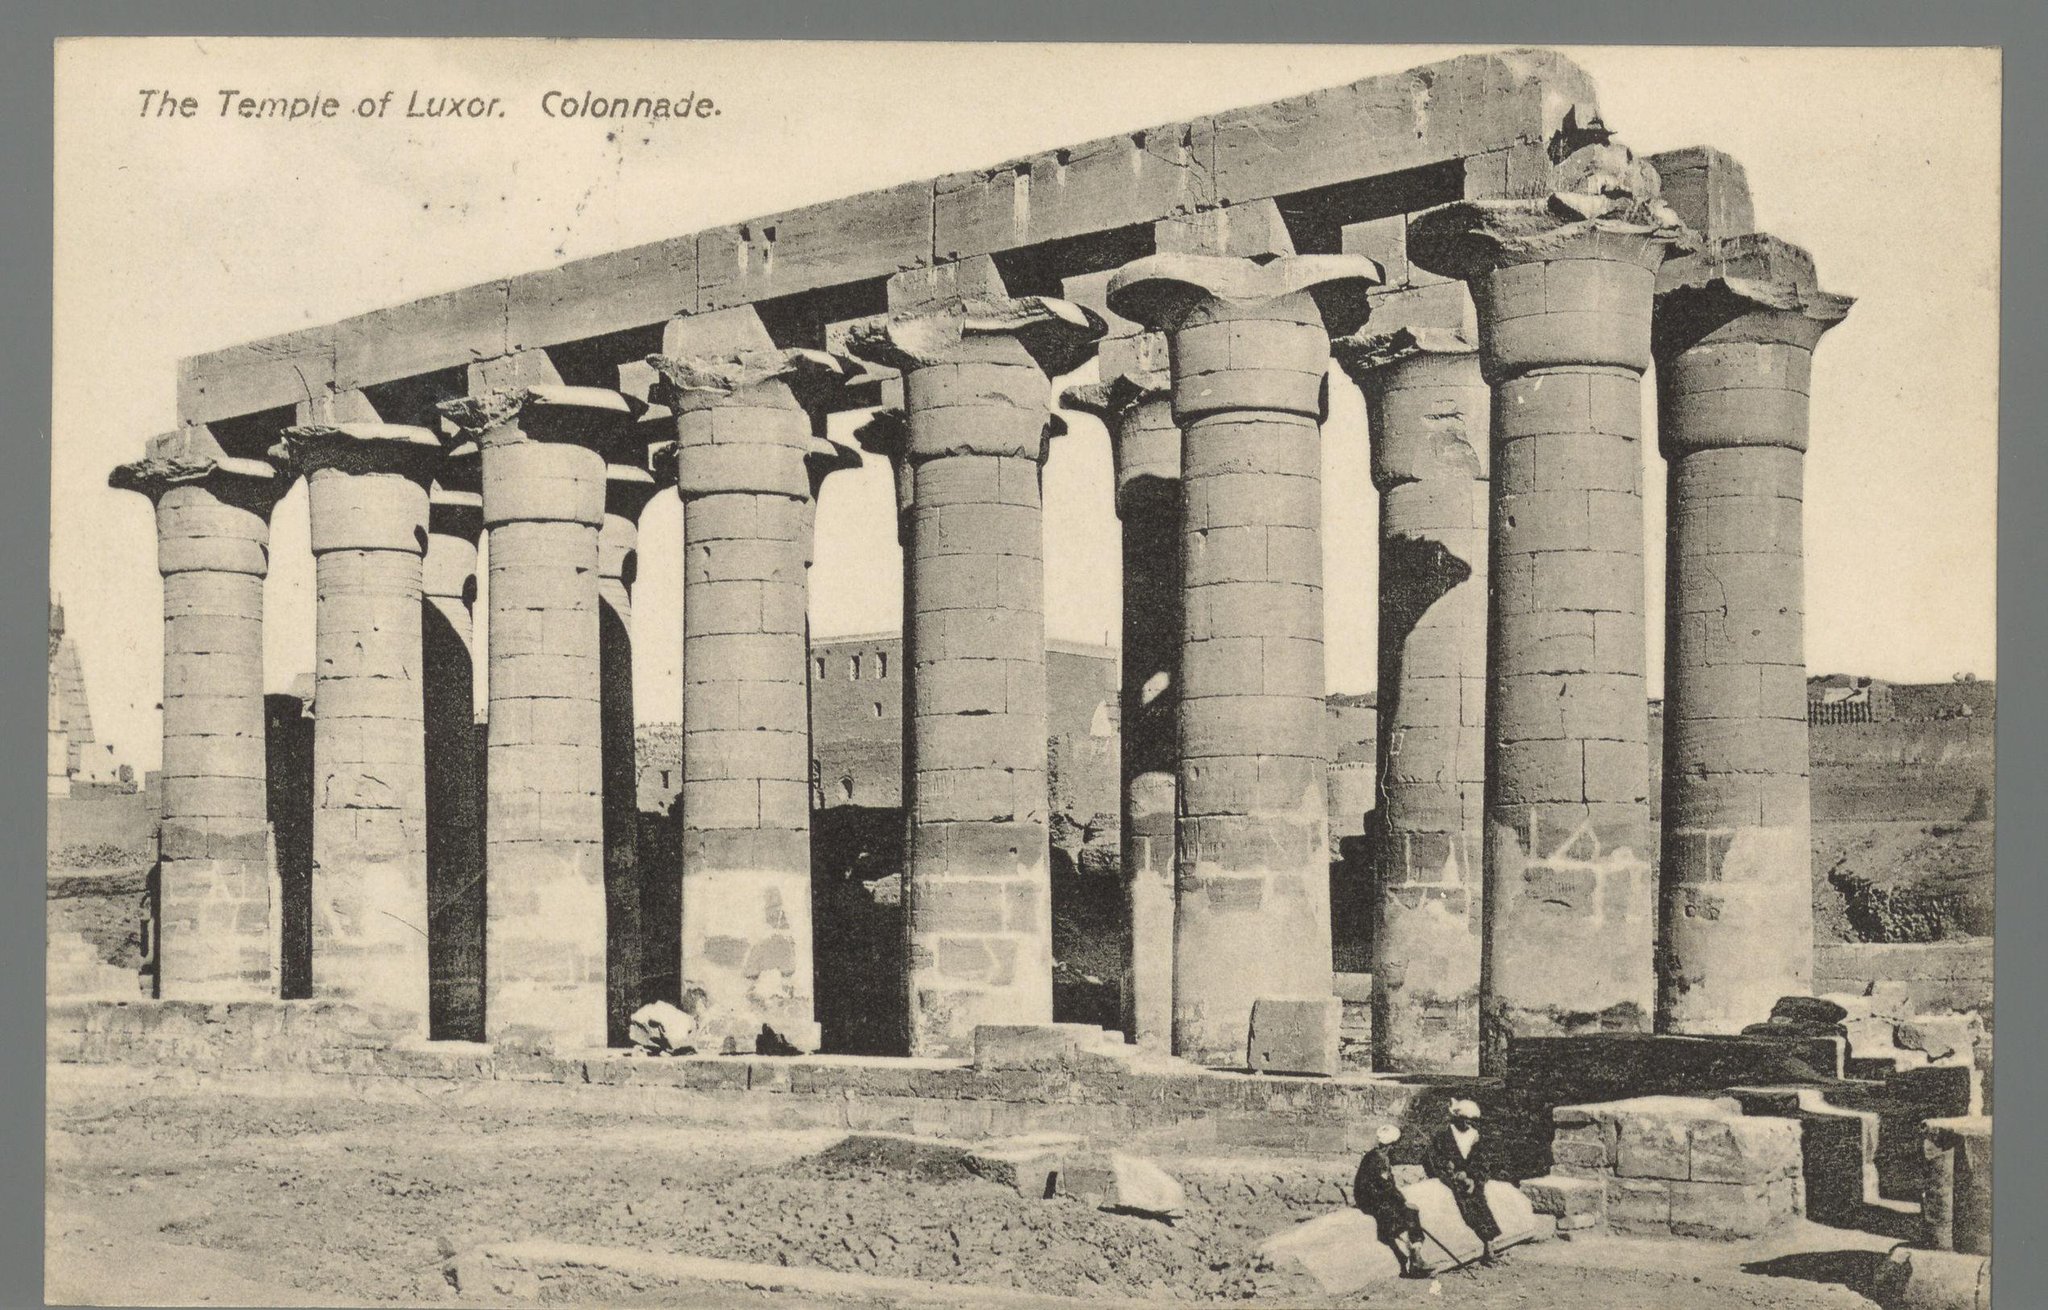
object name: photomechanical print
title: The Temple of Luxor. Colonnade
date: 1907-1930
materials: cardboard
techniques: photograph, writing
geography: luxor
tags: temple, shrine ~ egyptian religion, colonnade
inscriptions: postage stamp, monogram: ‘LC’